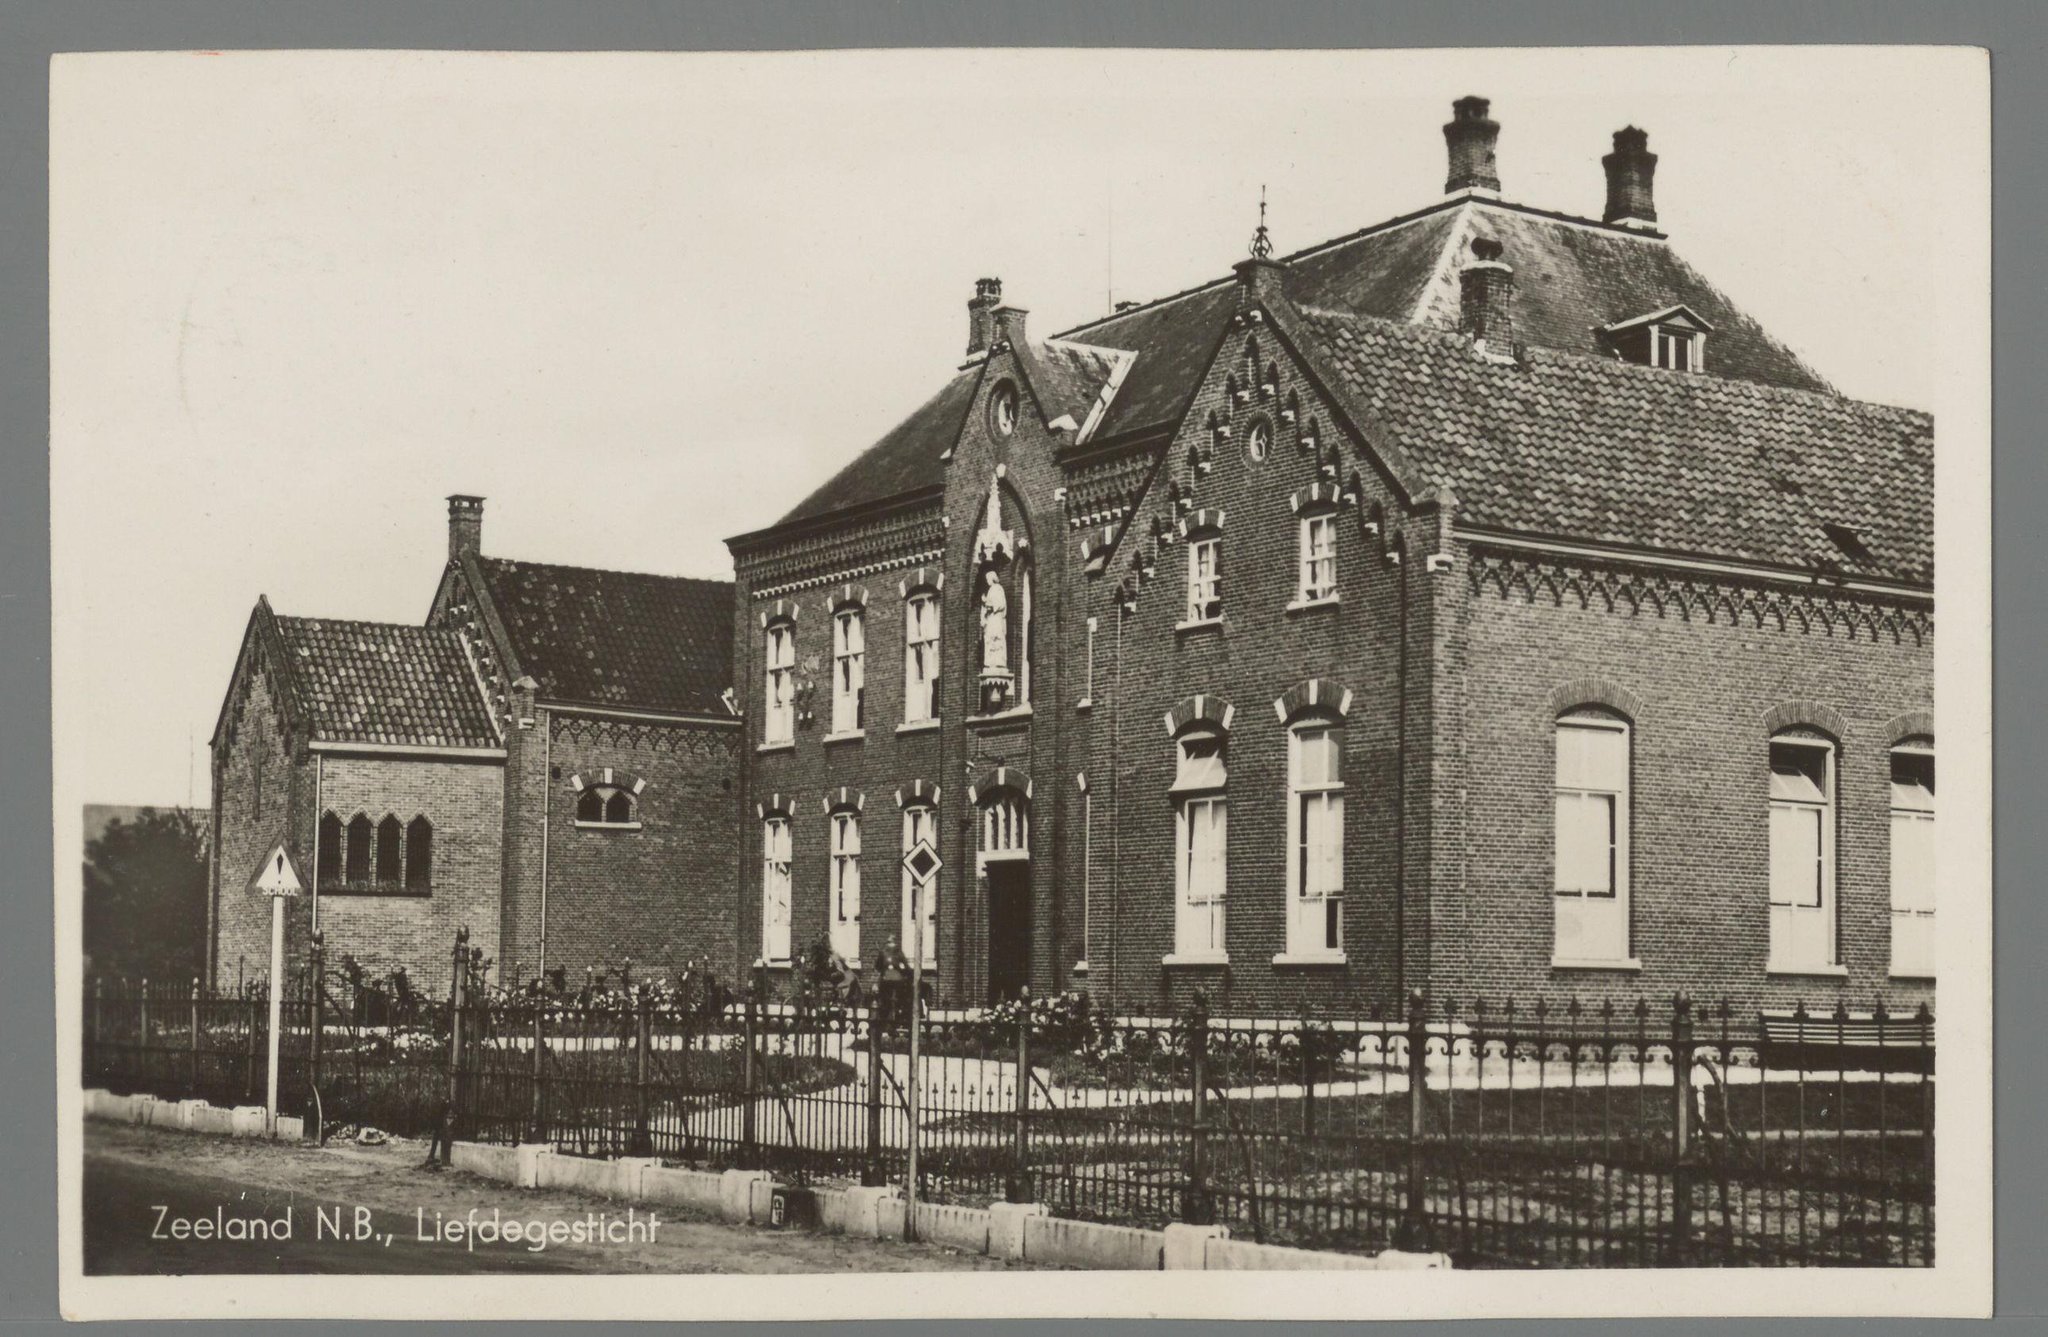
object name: photograph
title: Zeeland N.B., Liefdegesticht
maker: Anonymous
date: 1942-1943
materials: paper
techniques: gelatin silver print, writing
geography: zeeland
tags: lunatic asylum, mental home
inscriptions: poststempel, verso, gestempeld